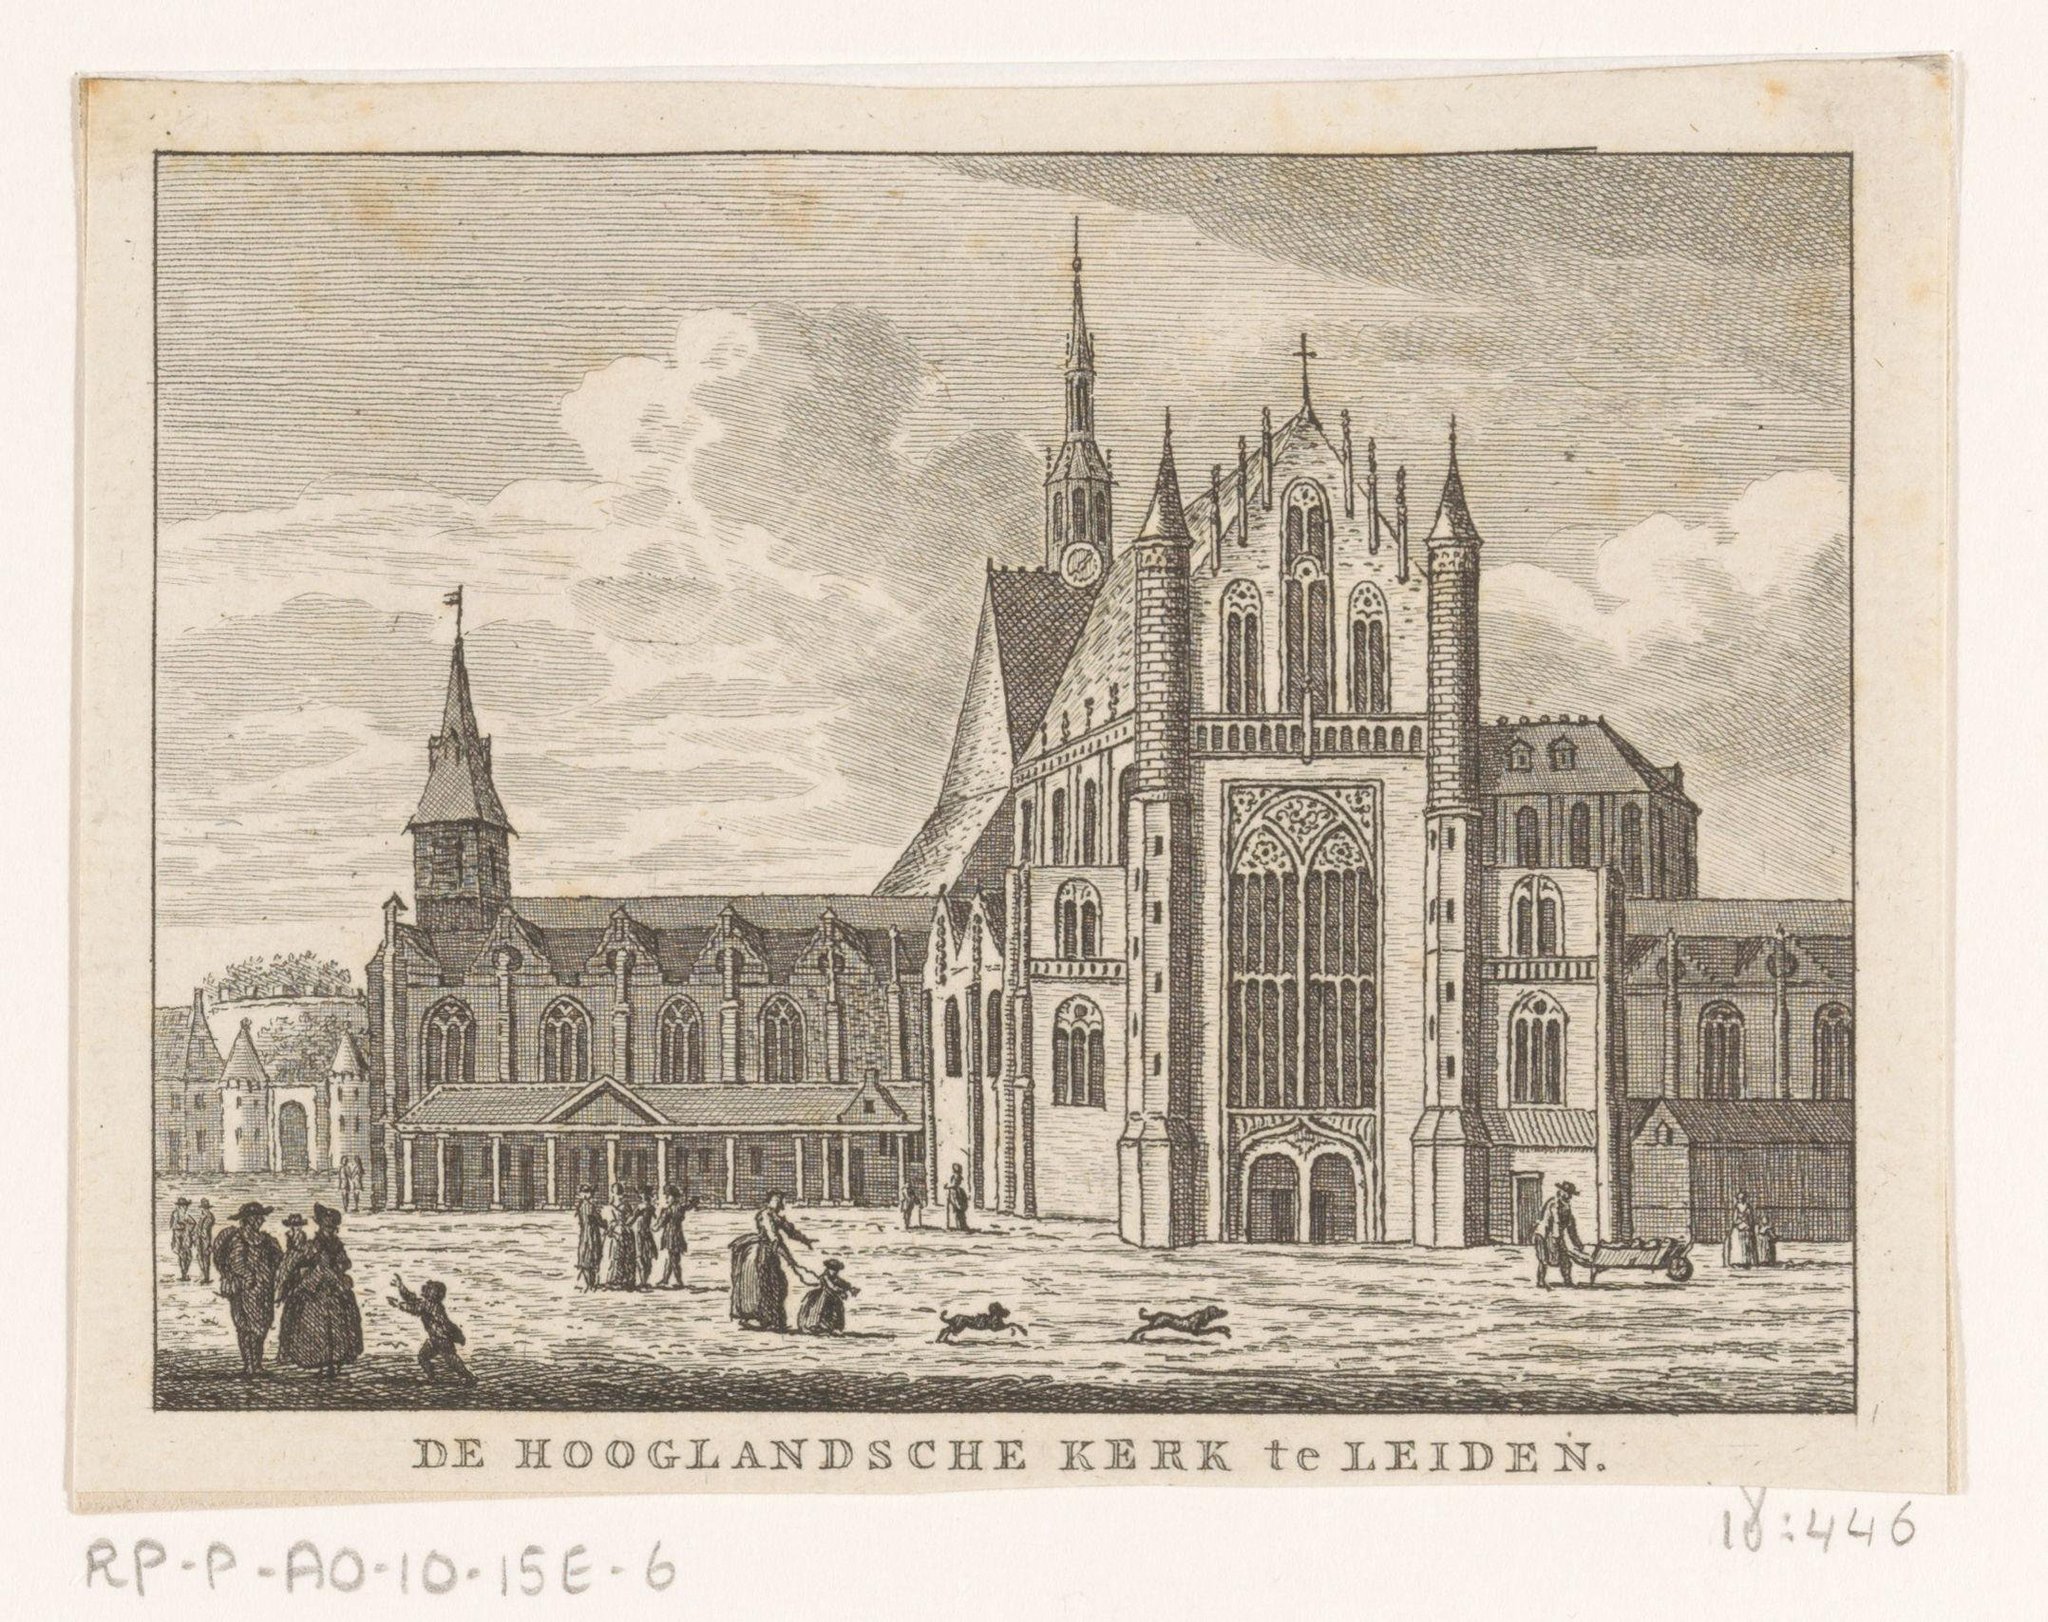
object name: print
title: De Hooglandsche kerk te Leiden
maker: carel frederik bendorp (i)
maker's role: print maker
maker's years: 1736-1814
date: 1786-1792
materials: paper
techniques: engraving, etching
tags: church (exterior)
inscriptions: collector's mark: Lugt 2228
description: Prent uit: Vaderlandsche gezichten, of afbeeldingen van den tegenwoordigen staat der Vereenigde Nederlanden (…). Amsterdam: Hendrik Gartman, Willem Vermandel en Jan Willem Smit, 1786-1792. Uitgegeven in afleveringen met ieder een eigen bifolium en inhoudsopgave. Alle prenten in deze publicatie zijn gegraveerd door Carel Frederik Bendorp (I) en, in de meeste gevallen, gebaseerd op tekeningen van Jan Bulthuis.